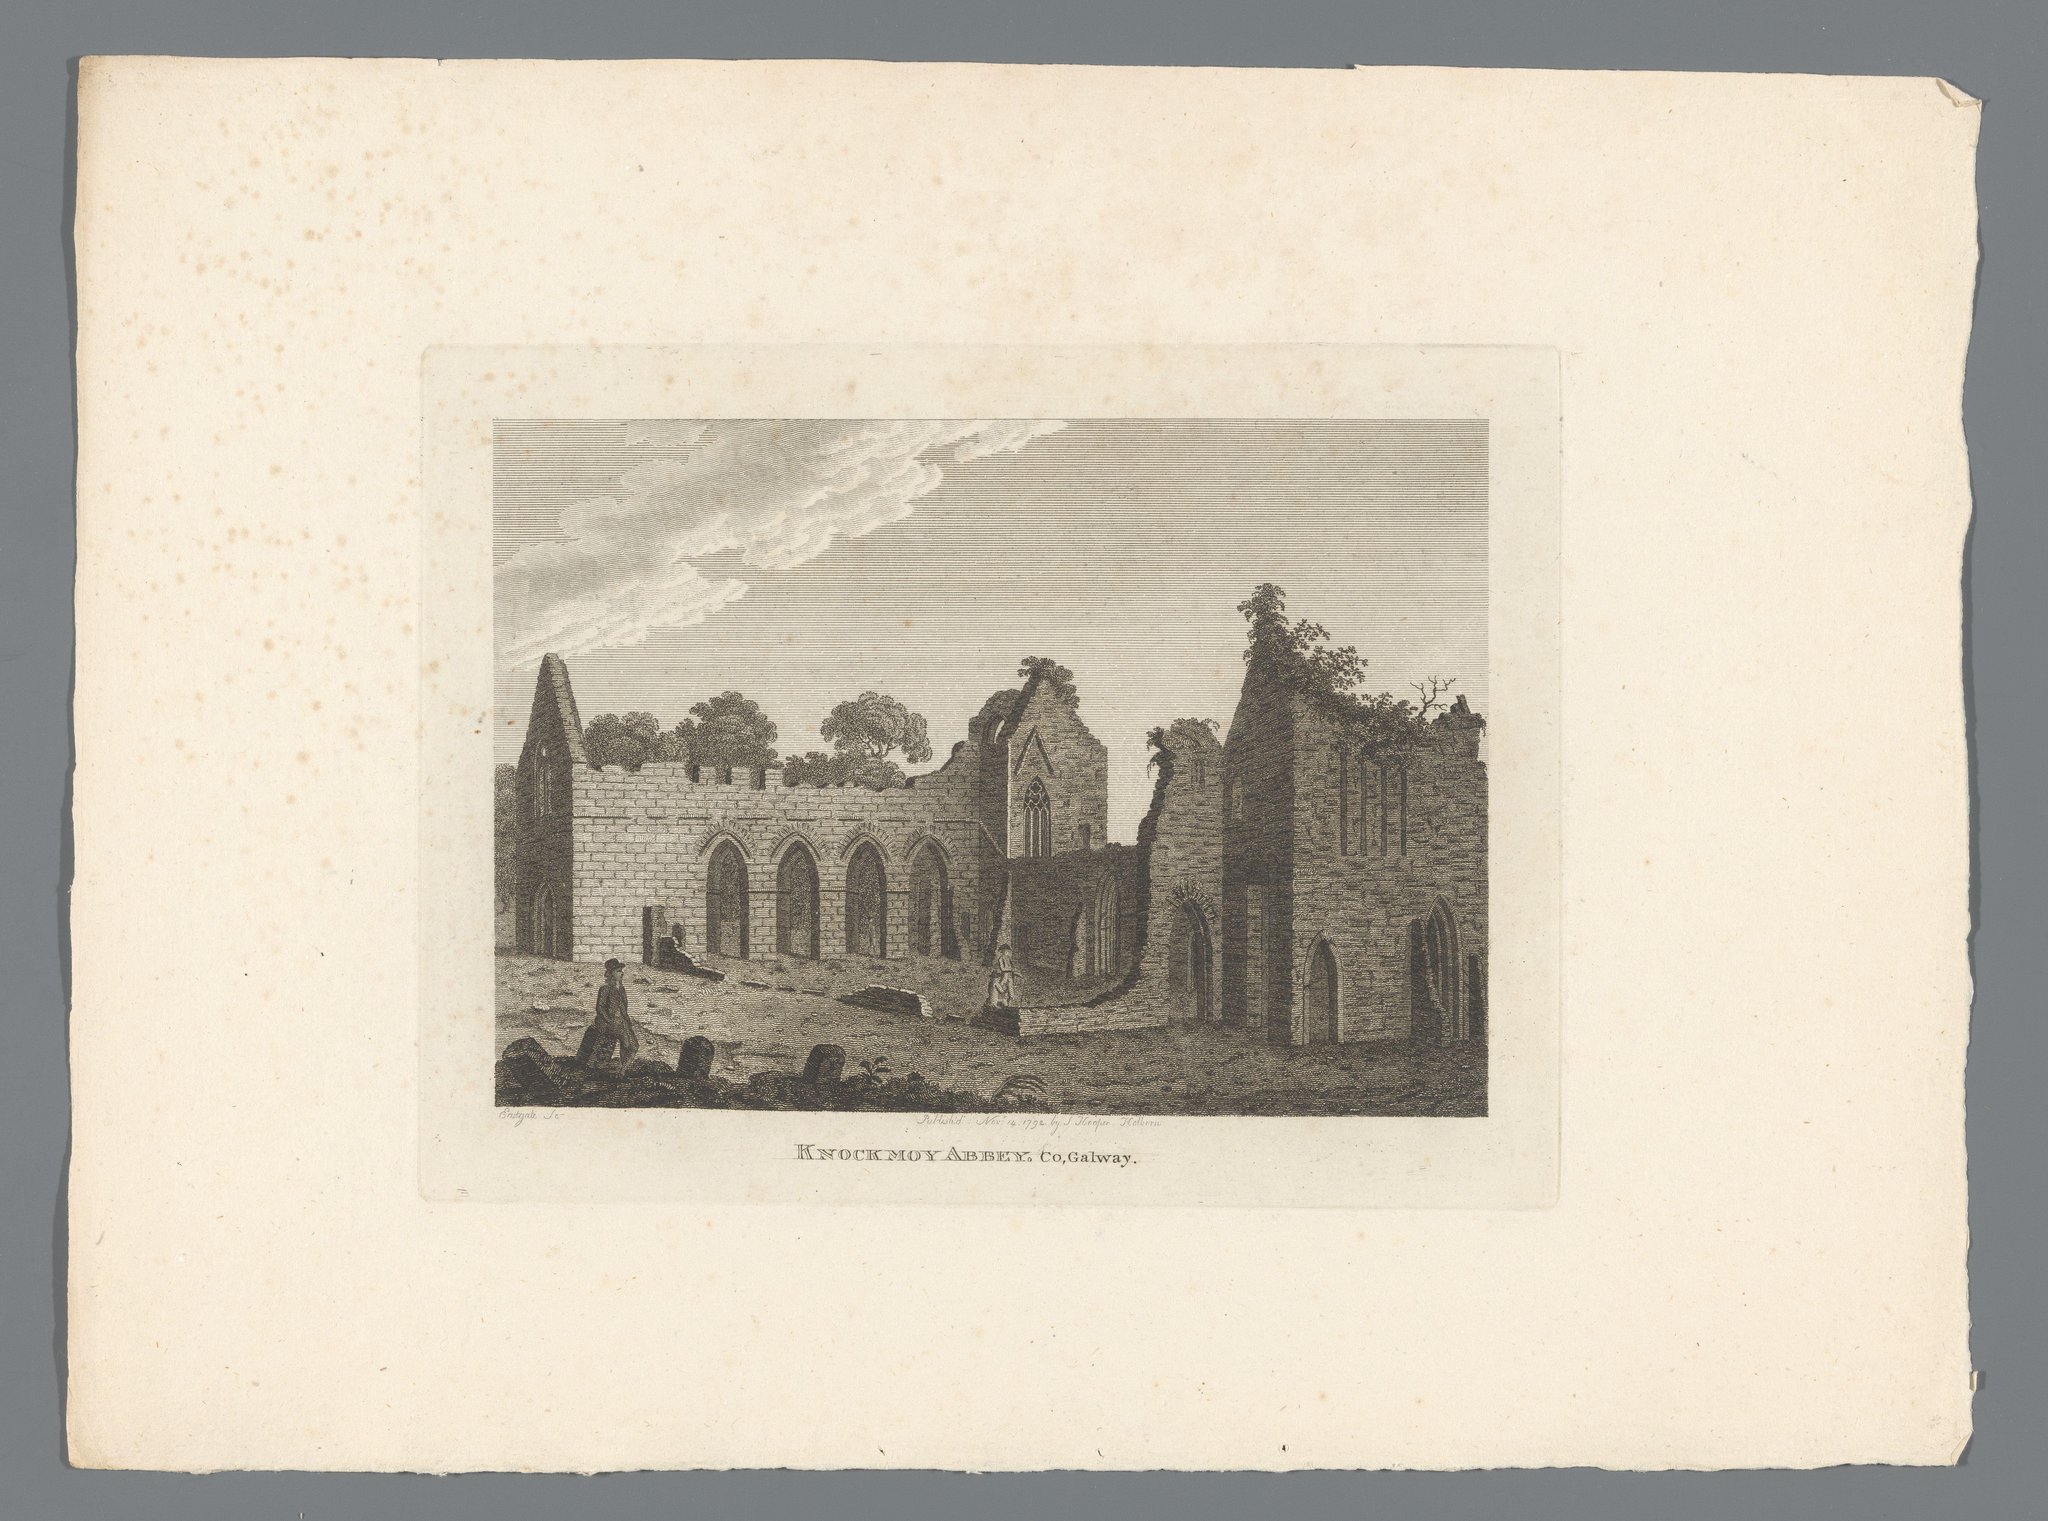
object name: print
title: Gezicht op de ruïnes van de abdij van Knockmoy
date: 1792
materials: paper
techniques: etching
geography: london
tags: abbey, monastery, convent ~ roman catholic church, landscape with ruins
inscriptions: date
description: Prent verschenen in: Grose, Francis. The antiquities of Ireland. Londen: S. Hooper, 1795, dl. 2.